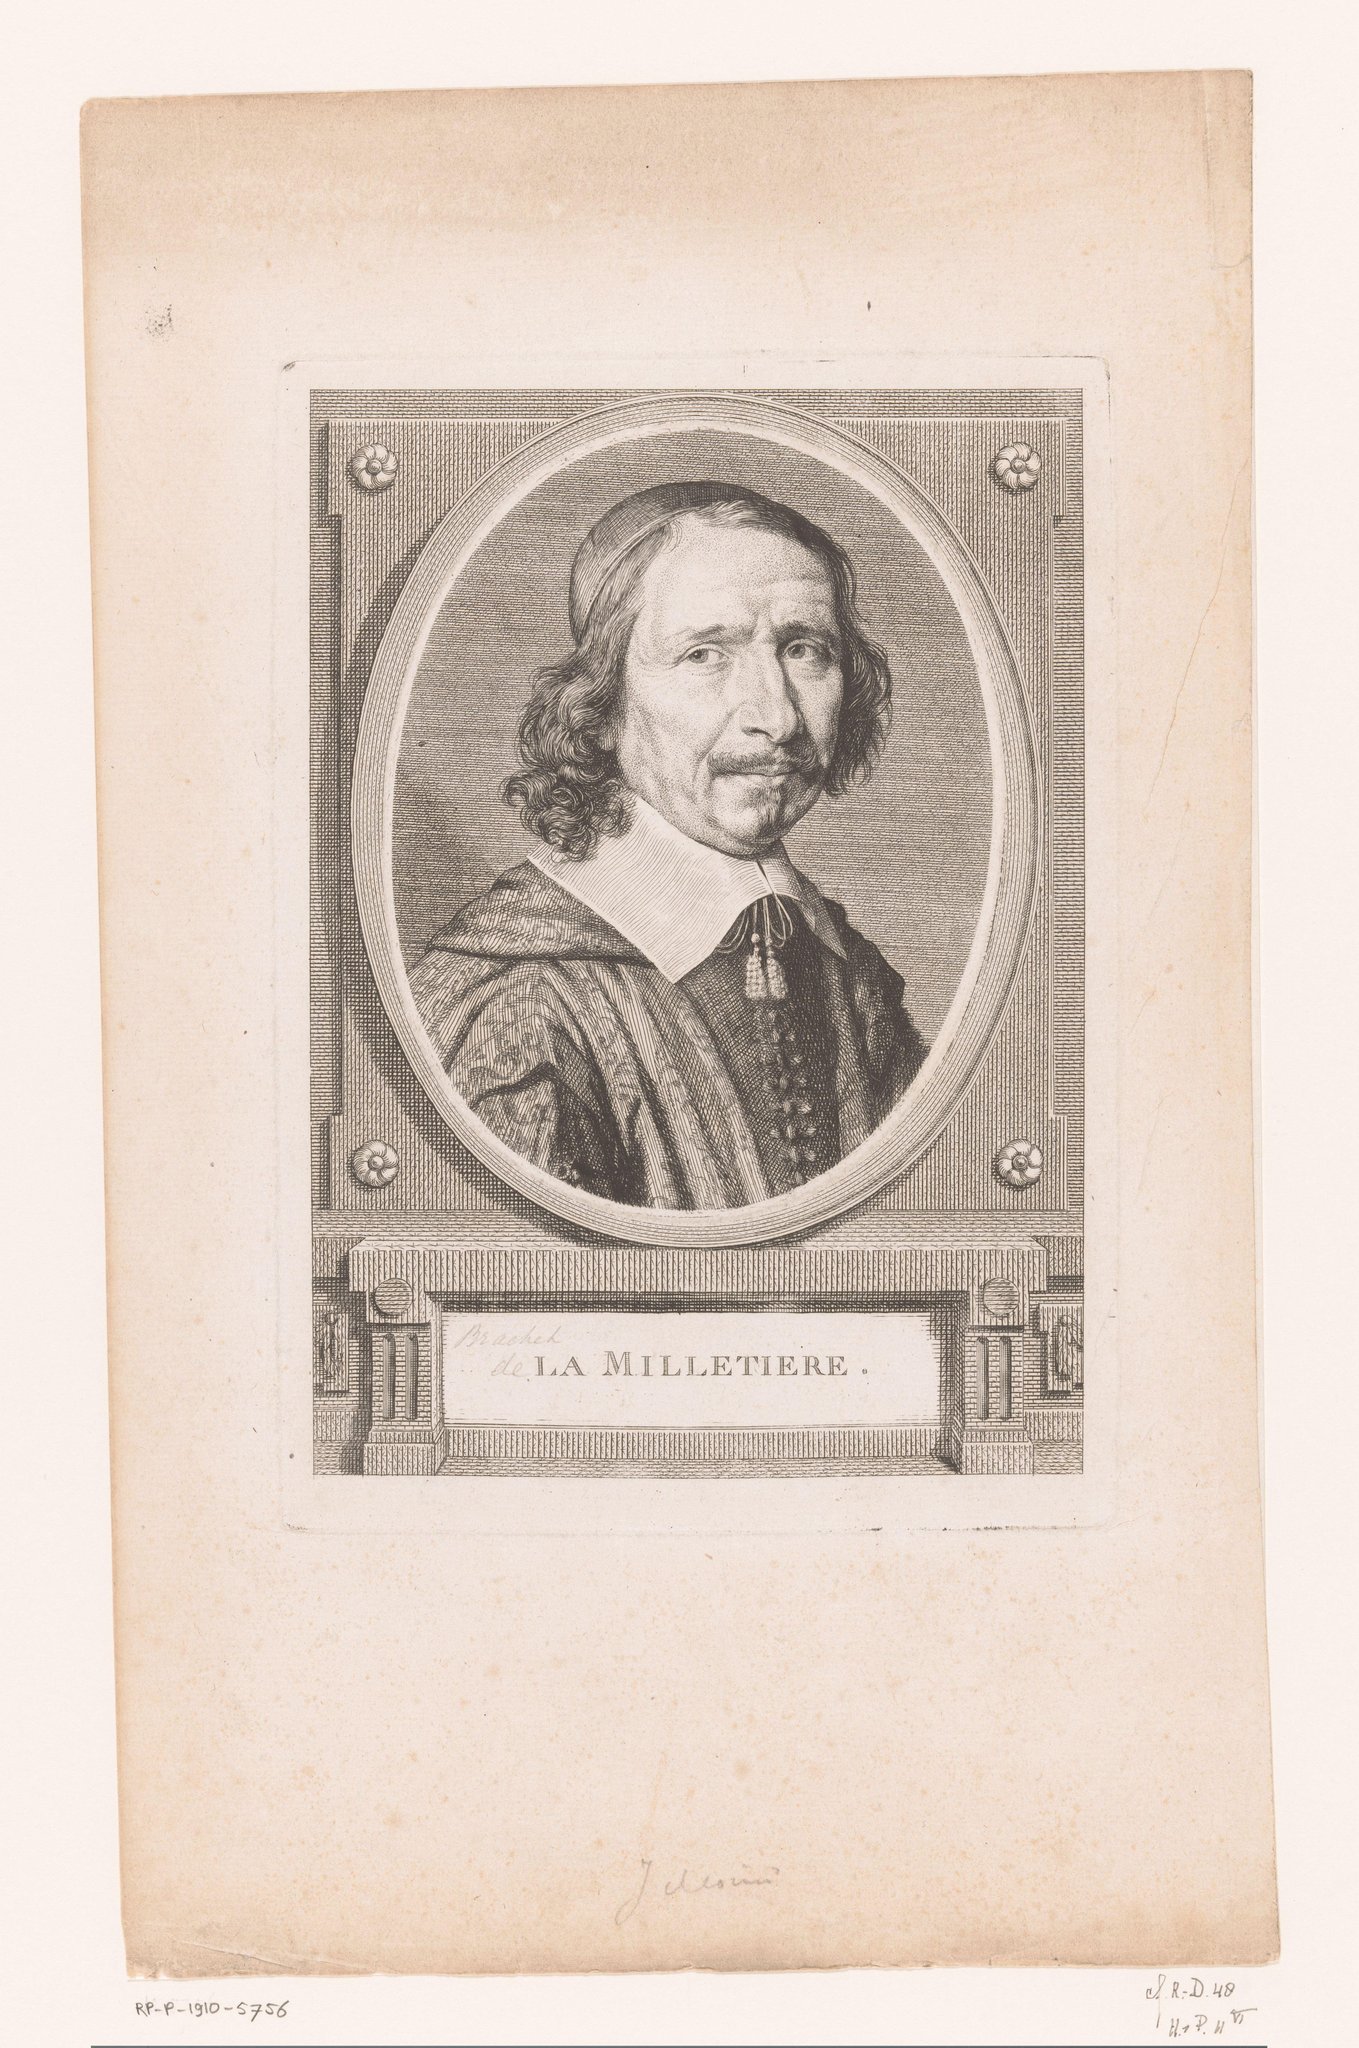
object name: print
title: La Milletiere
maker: jean morin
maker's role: print maker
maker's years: 1605-1650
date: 1636-1650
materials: paper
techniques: engraving, etching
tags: theologian, historical persons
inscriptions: collector's mark: Lugt 2228